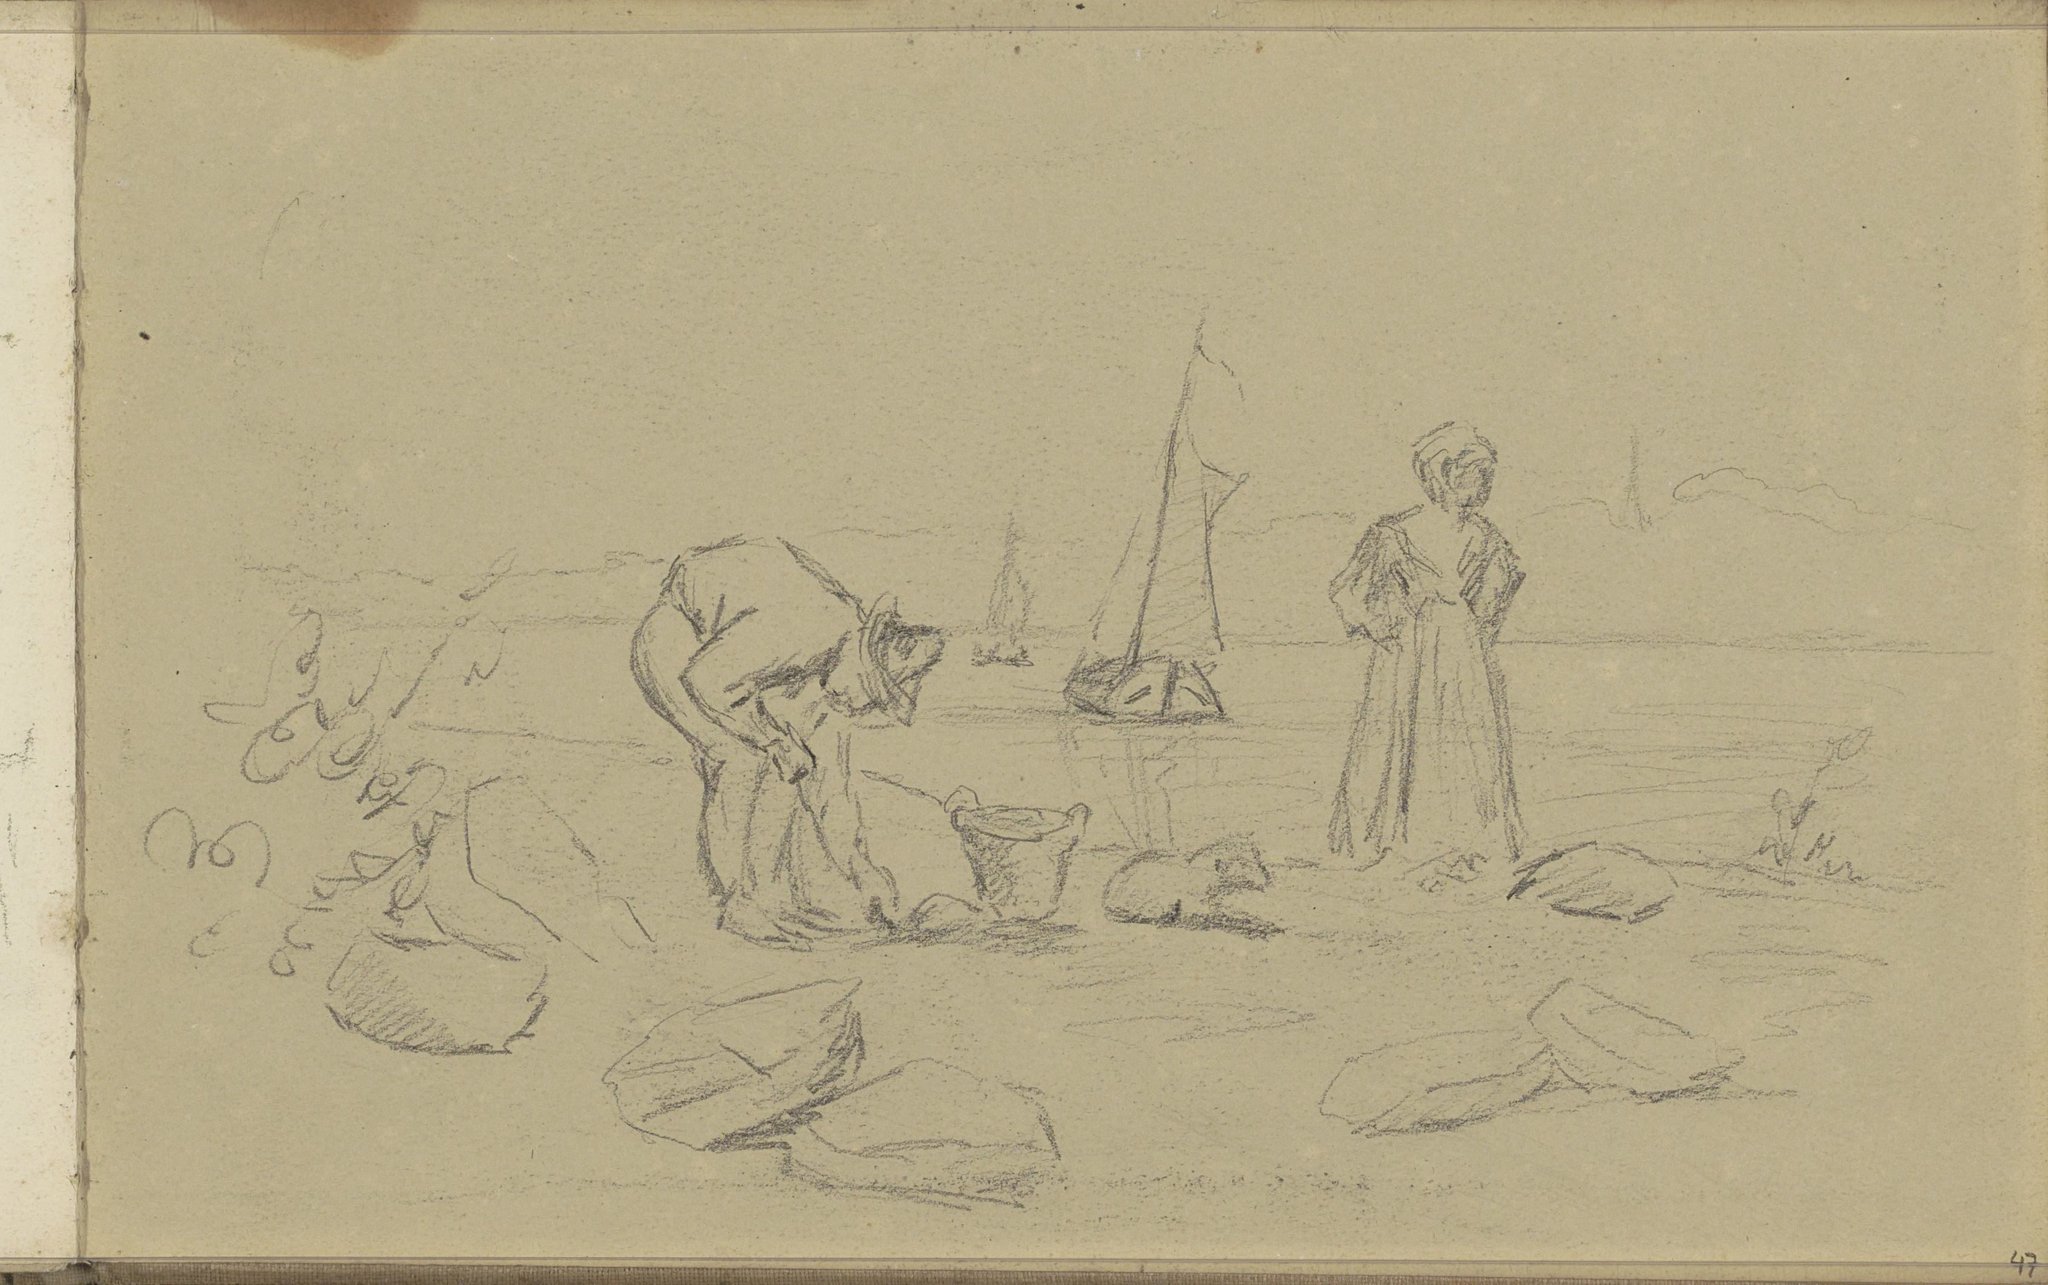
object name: sketchbook leaf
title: Twee aardappelrooiers langs een kade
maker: willem cornelis rip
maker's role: draughtsman, painter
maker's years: 1856-1922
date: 1874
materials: paper, pencil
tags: plants cultivated for their edible roots or tubers, e.g. potato, turnip (labourers ~ crafts, industries, agriculture), landscapes with waters, waterscapes, seascapes (in the temperate zone) (+ landscape with figures, staffage)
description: Op de achtergrond zeilboten op een rivier en heuvels. Blad 47 recto uit een schetsboek met 47 bladen.